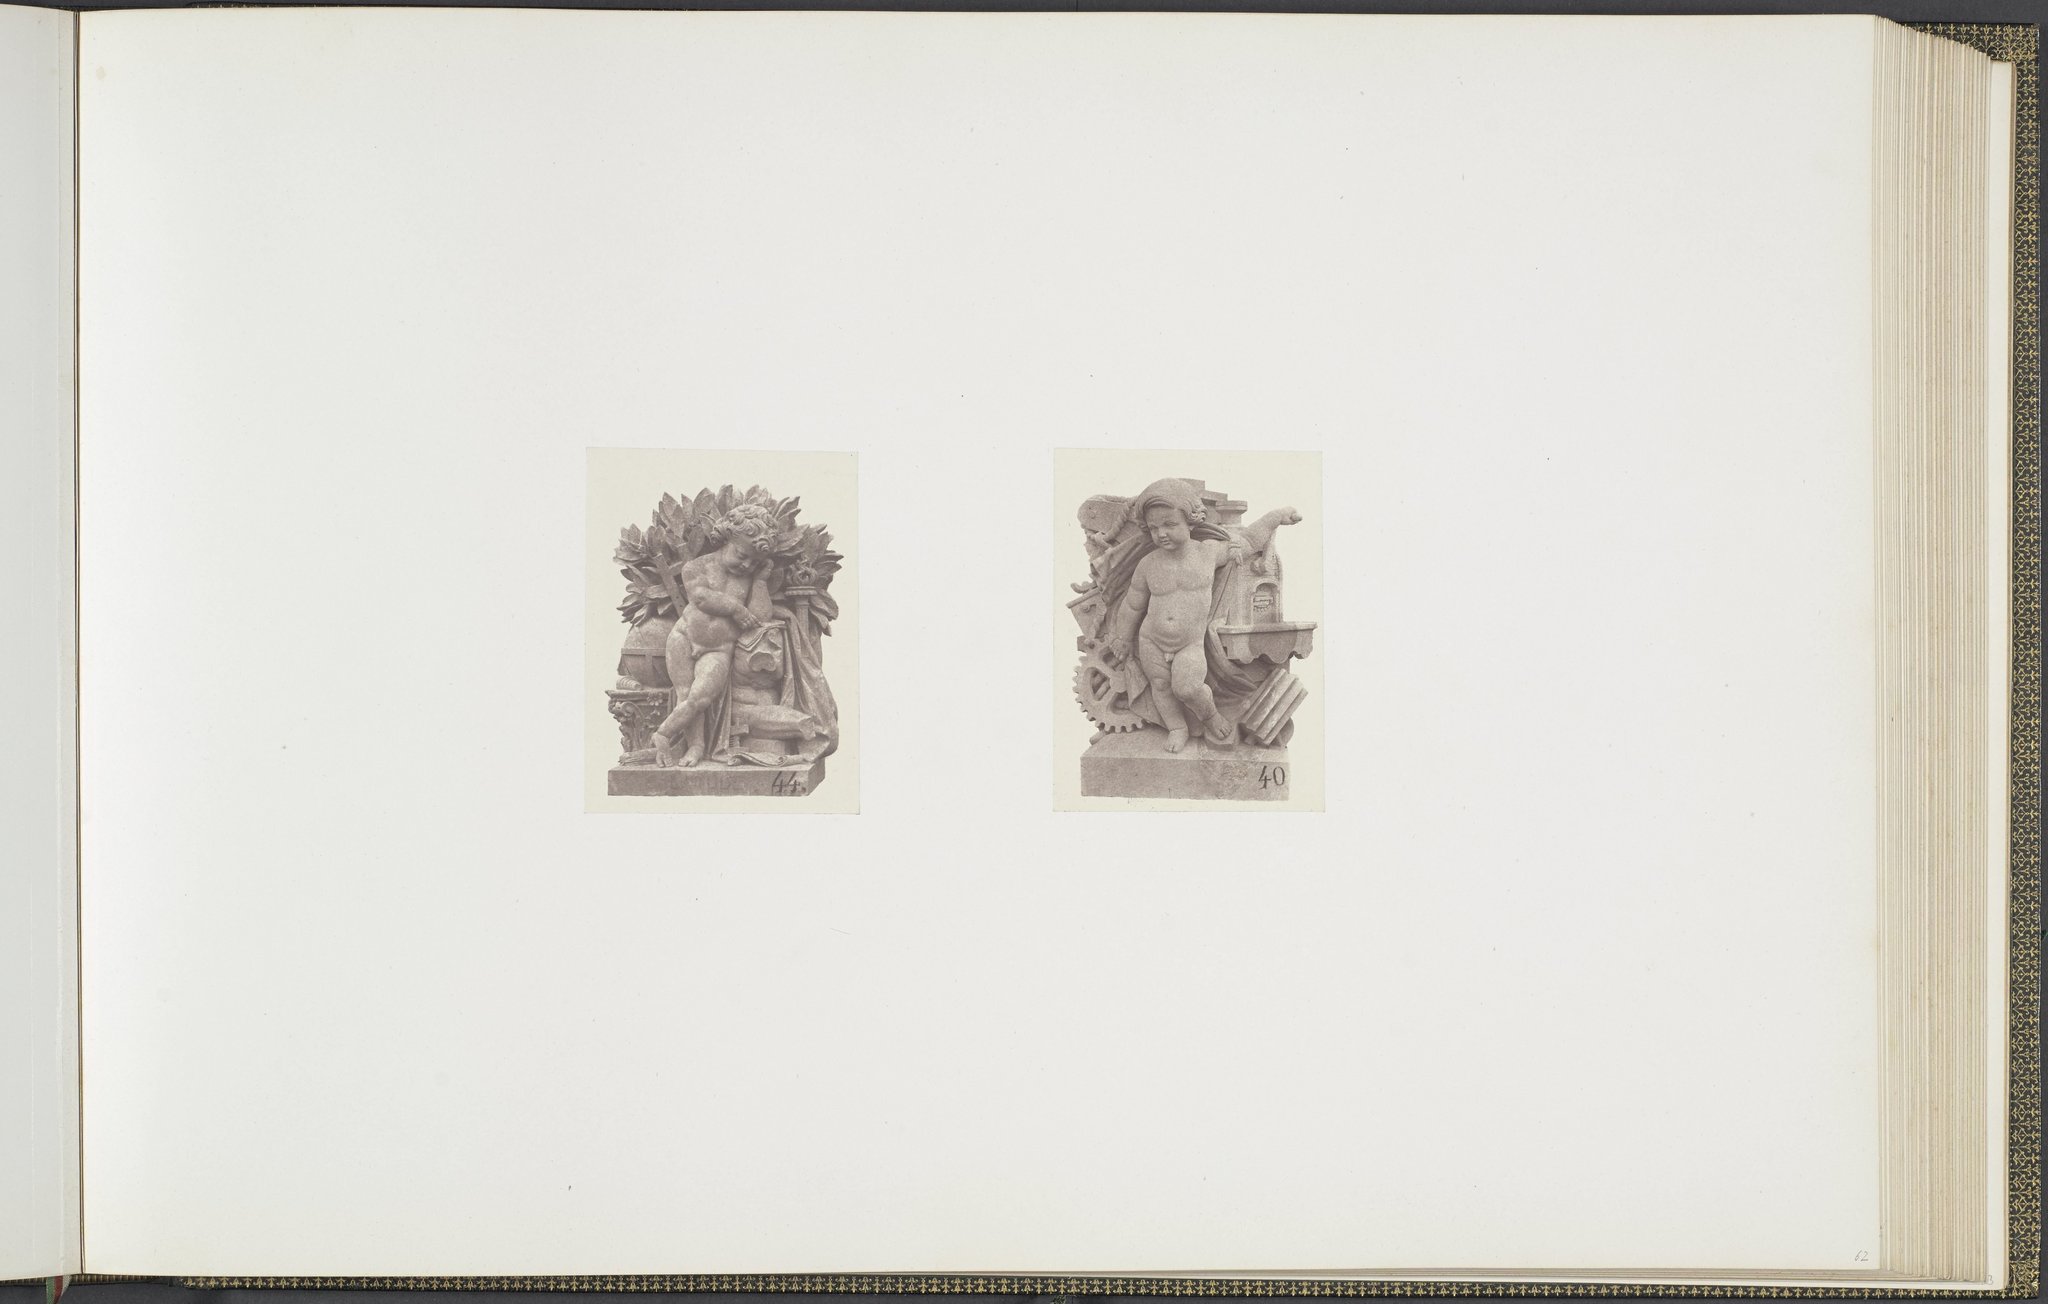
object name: album leaf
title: Gipsmodellen voor beeldhouwwerken op het Palais du Louvre: links "L'Etude" door Antoine-Samuel Adam-Salomon en rechts "L'Industrie" door Pierre Damiens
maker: édouard denis baldus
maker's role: fotograaf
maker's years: 1813-1889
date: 1855-1857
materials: paper, photographic support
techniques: salted paper print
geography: paris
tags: piece of sculpture, reproduction of a piece of sculpture, permanent exhibition, museum, paris, tuileries palace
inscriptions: number: ‘44 en 40’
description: Onderdeel van Réunion des Tuileries au Louvre 1852-1857, album 1.